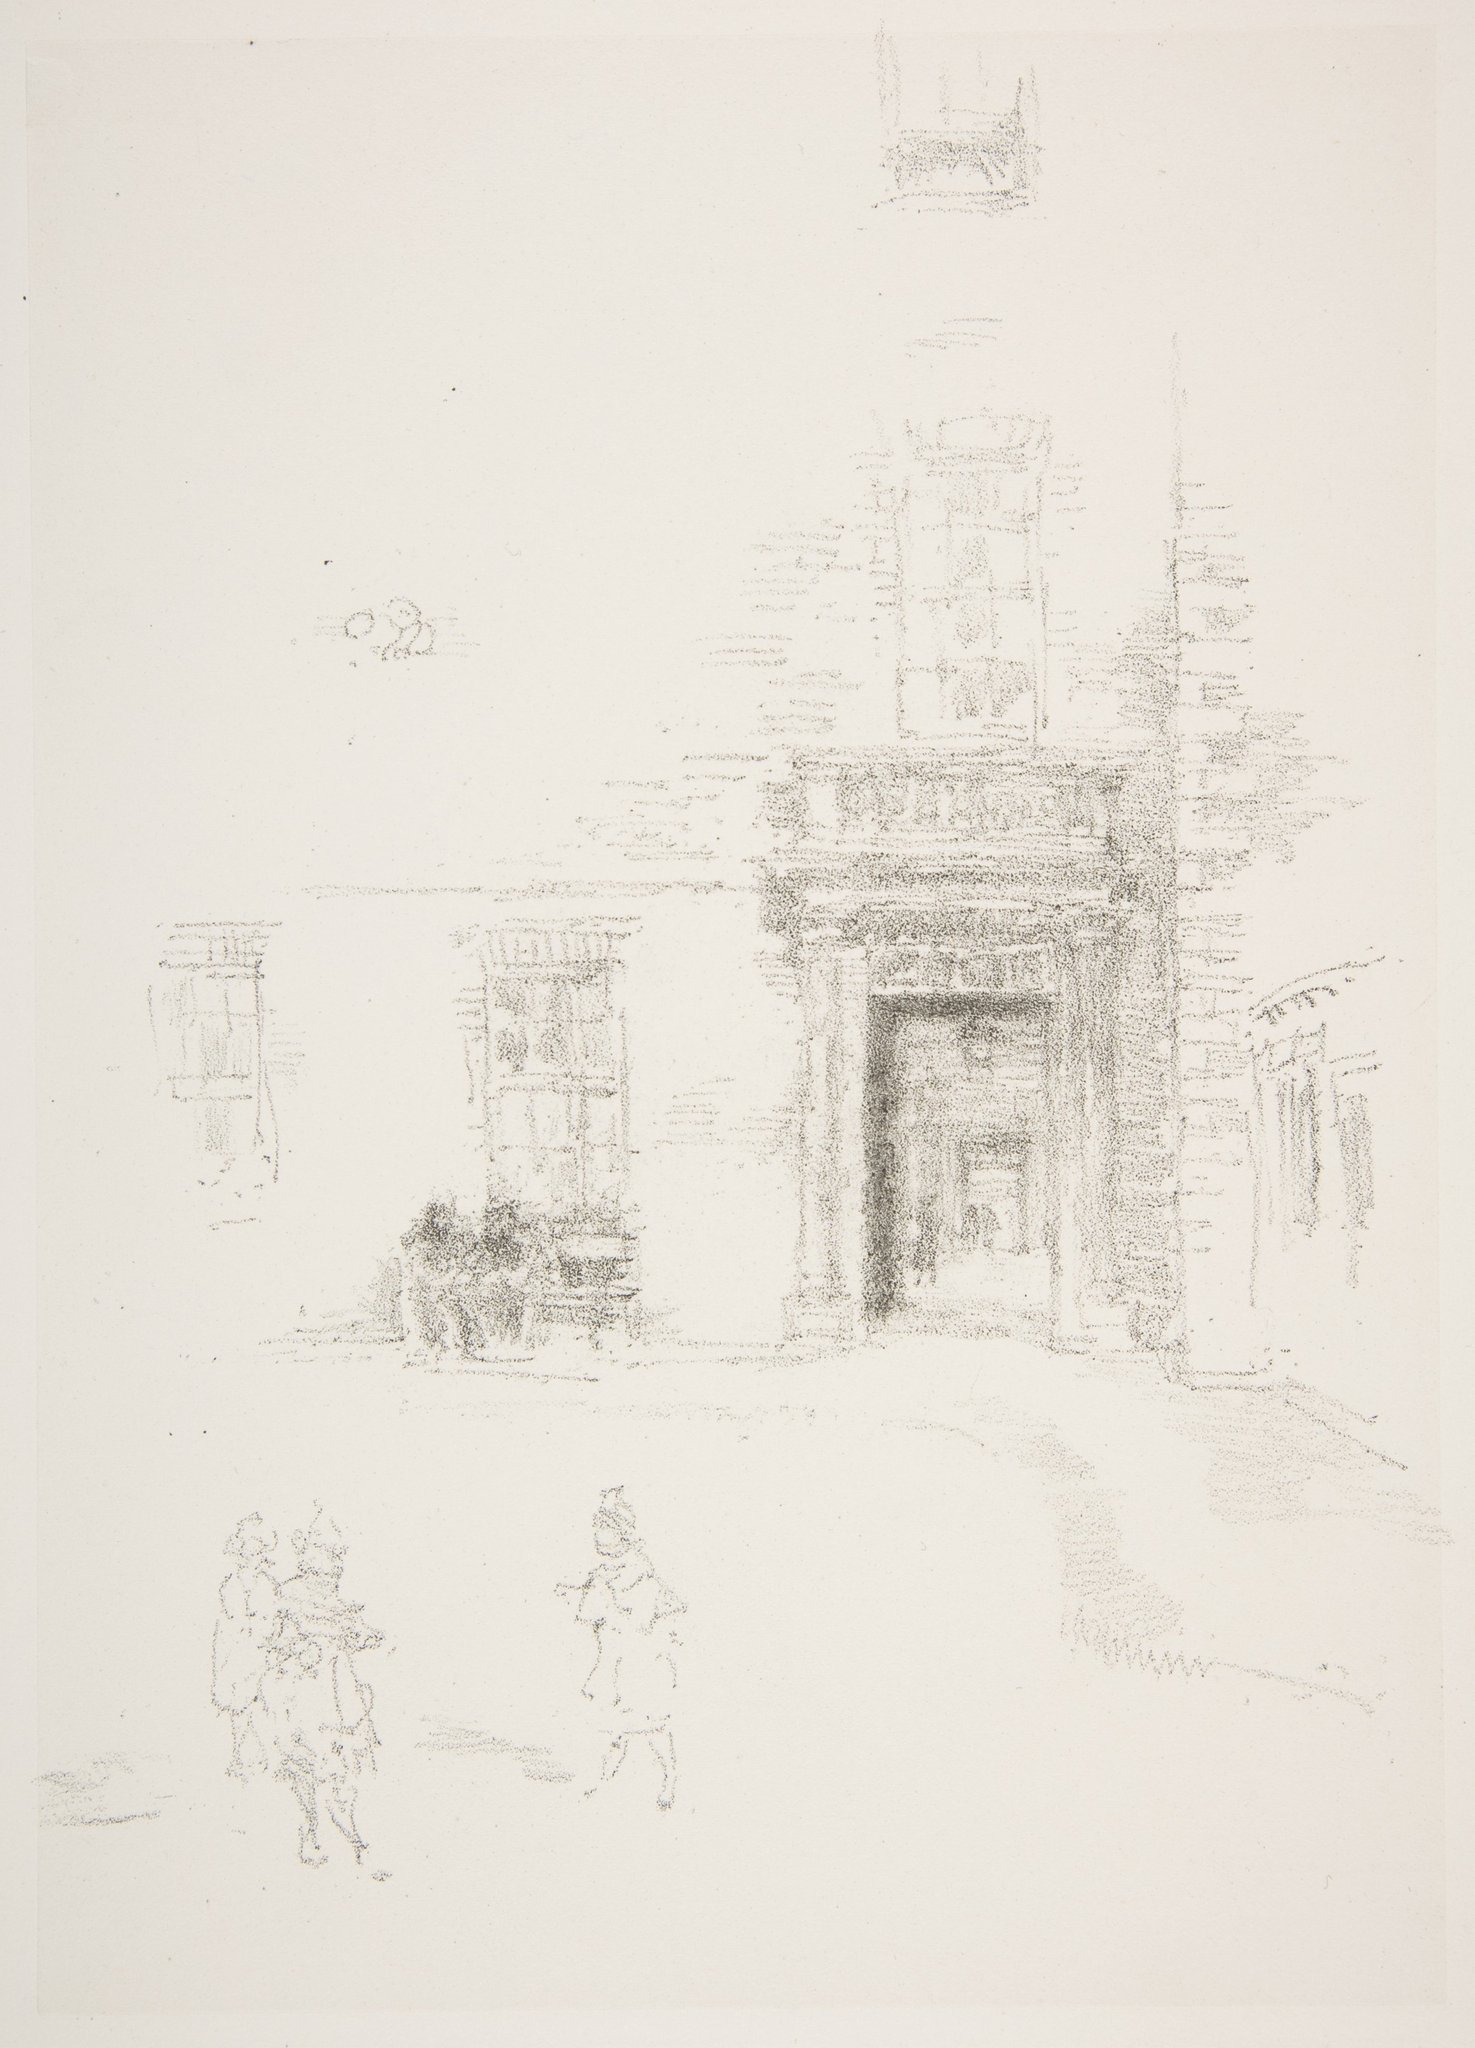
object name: print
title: Courtyard, Chelsea Hospital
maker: james mcneill whistler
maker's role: artist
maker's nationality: american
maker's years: 1834-1903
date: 1888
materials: chine, paper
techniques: lithograph, stumping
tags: hospitals,courtyards